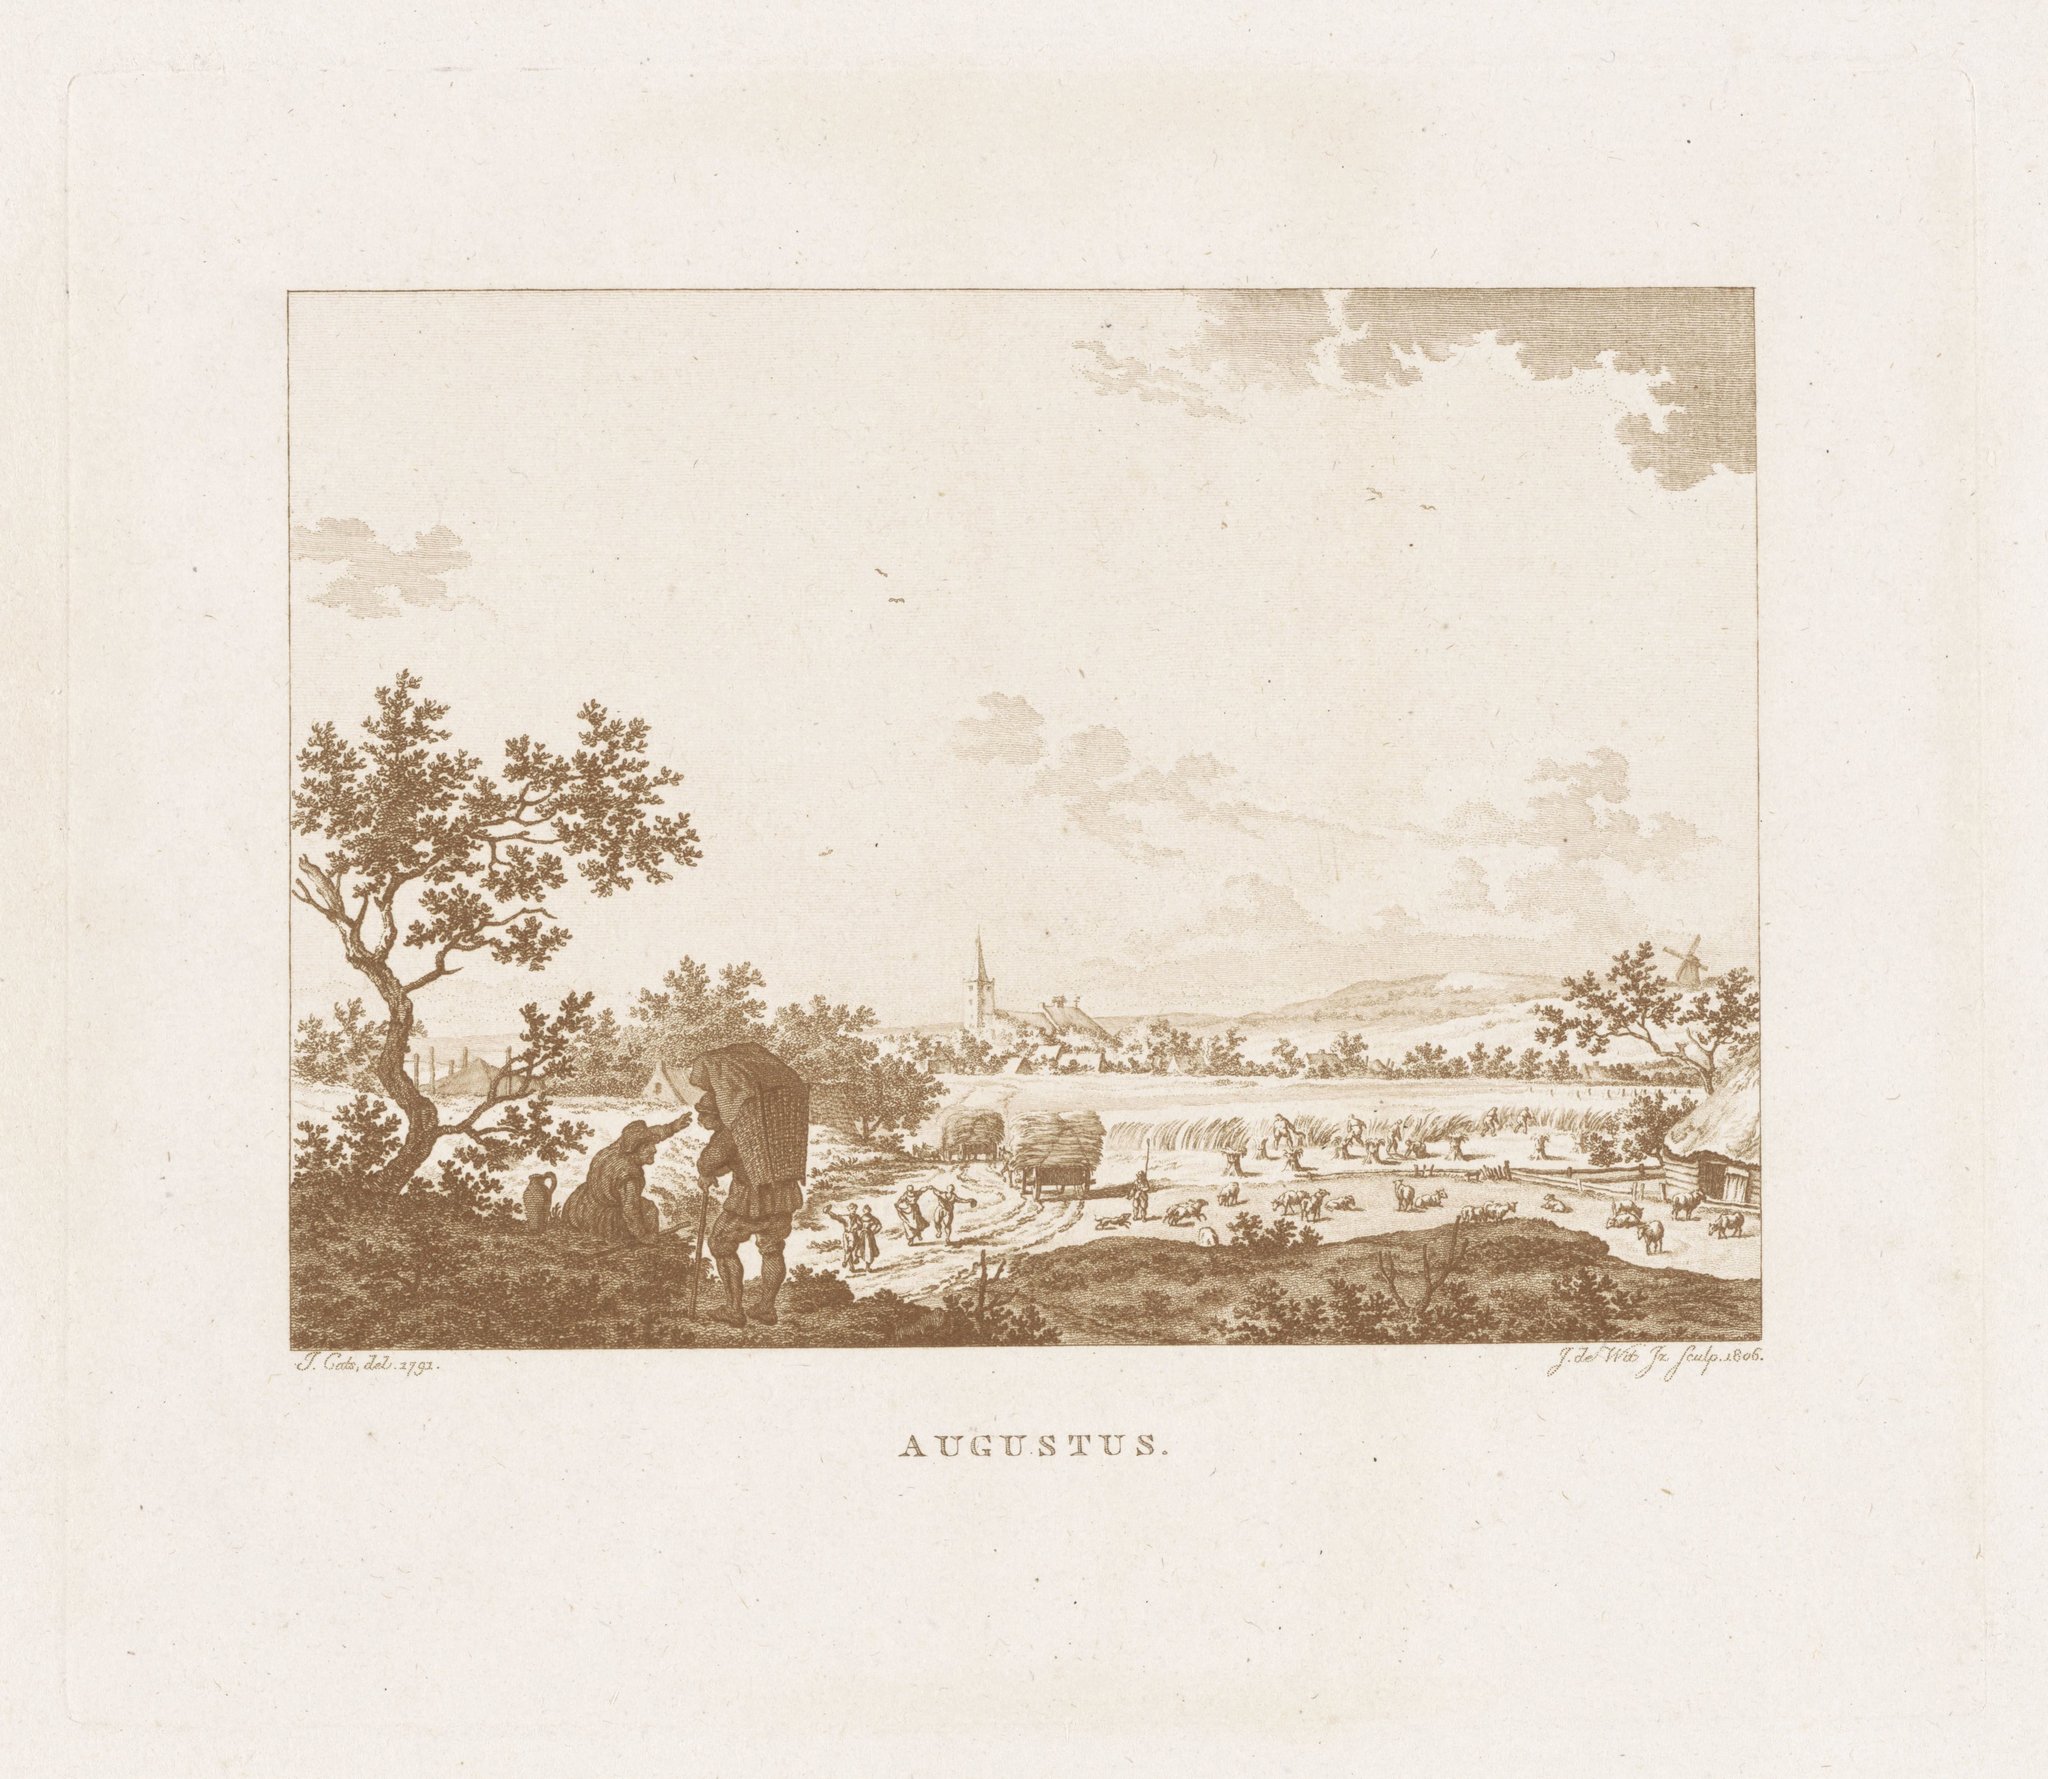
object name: print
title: Weids landschap met korenoogst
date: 1806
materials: paper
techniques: etching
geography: haarlem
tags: harvest festivities, august and its 'labours' (+ with scenes showing human occupations ~ seasons and months), pedlar, transporting ~ harvest, hay-wagon, reaping, picking, mowing ~ harvest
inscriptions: collector's mark: Lugt 2228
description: Een weids landschap met op de voorgrond een man met mand op de rug in gesprek met een zittende vrouw. In de verte wordt een korenveld gemaaid.